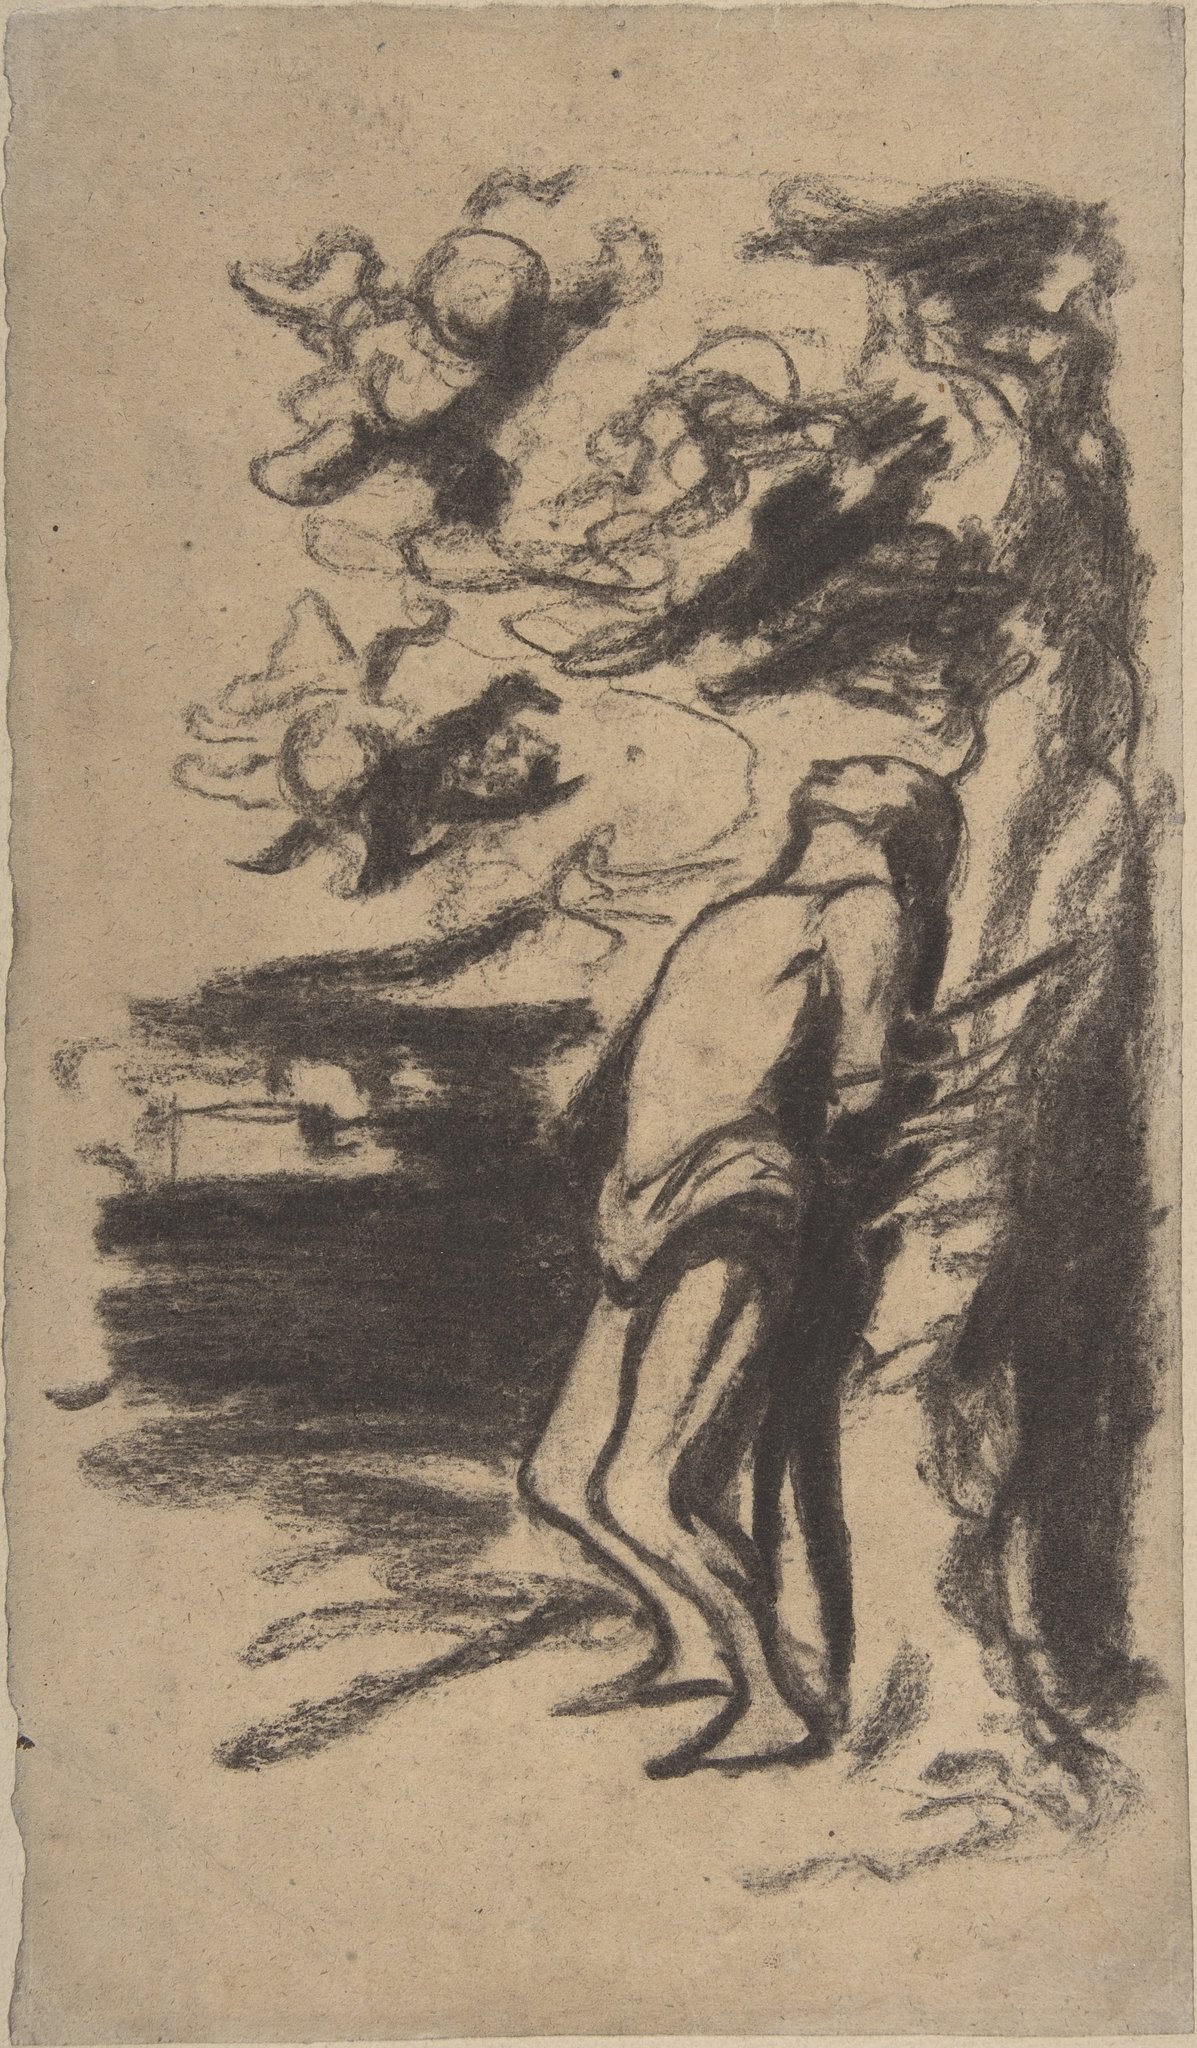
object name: drawing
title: Saint Sebastian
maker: honoré daumier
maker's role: artist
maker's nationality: french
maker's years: 1808-1879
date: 1849-1850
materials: charcoal, paper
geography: france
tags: angels,saints